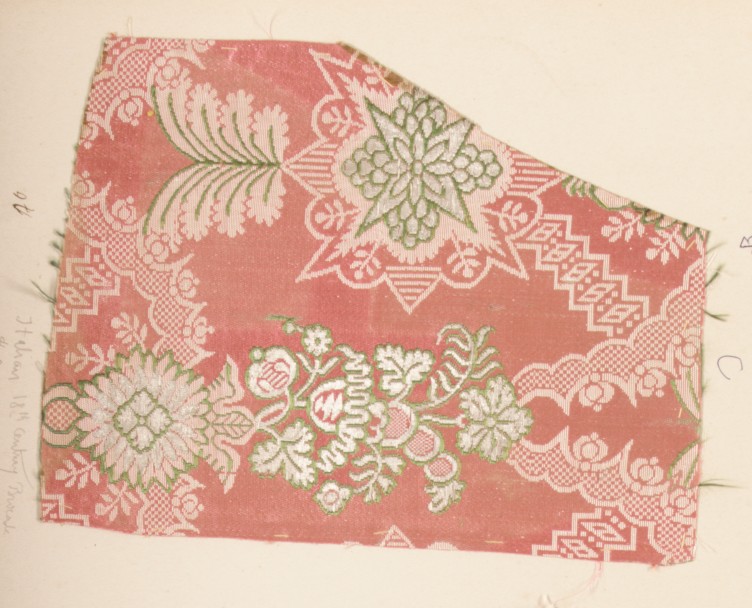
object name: fragment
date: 1701-1800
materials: silk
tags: flowers,leaves